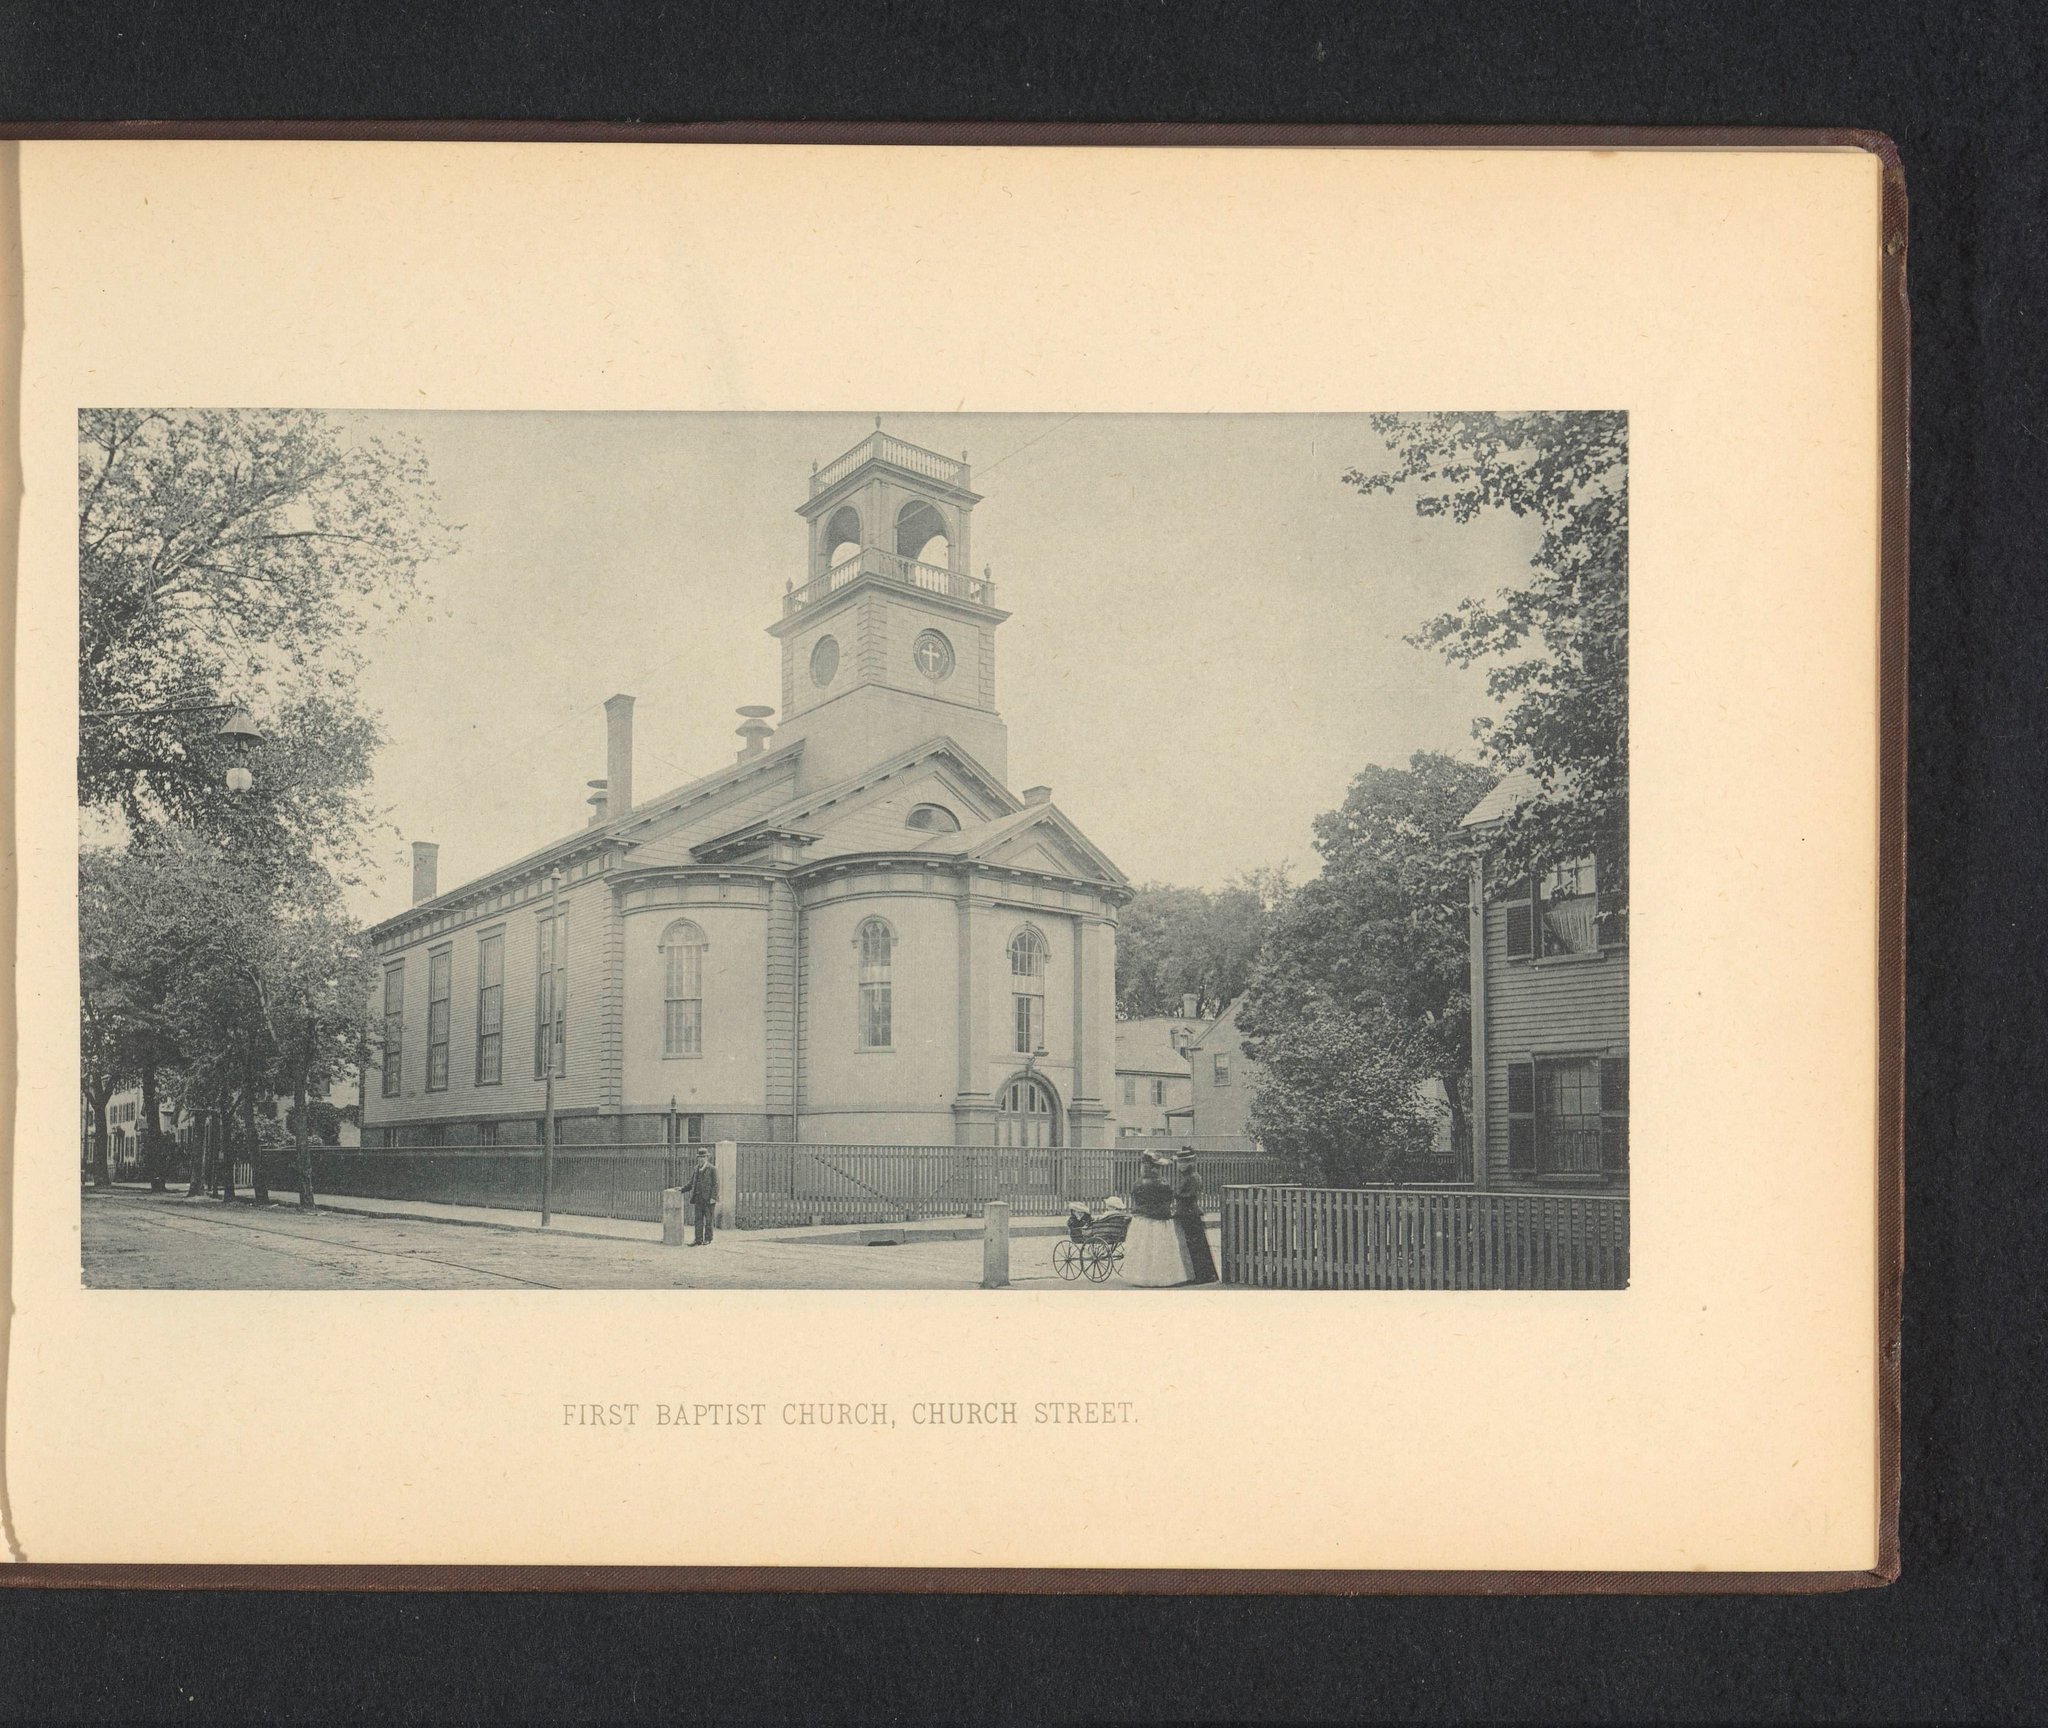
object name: photomechanical print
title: Gezicht op de First United Baptist Church te Lowell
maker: Anonymous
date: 1887-1892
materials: paper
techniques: photograph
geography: lowell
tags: church (exterior), street